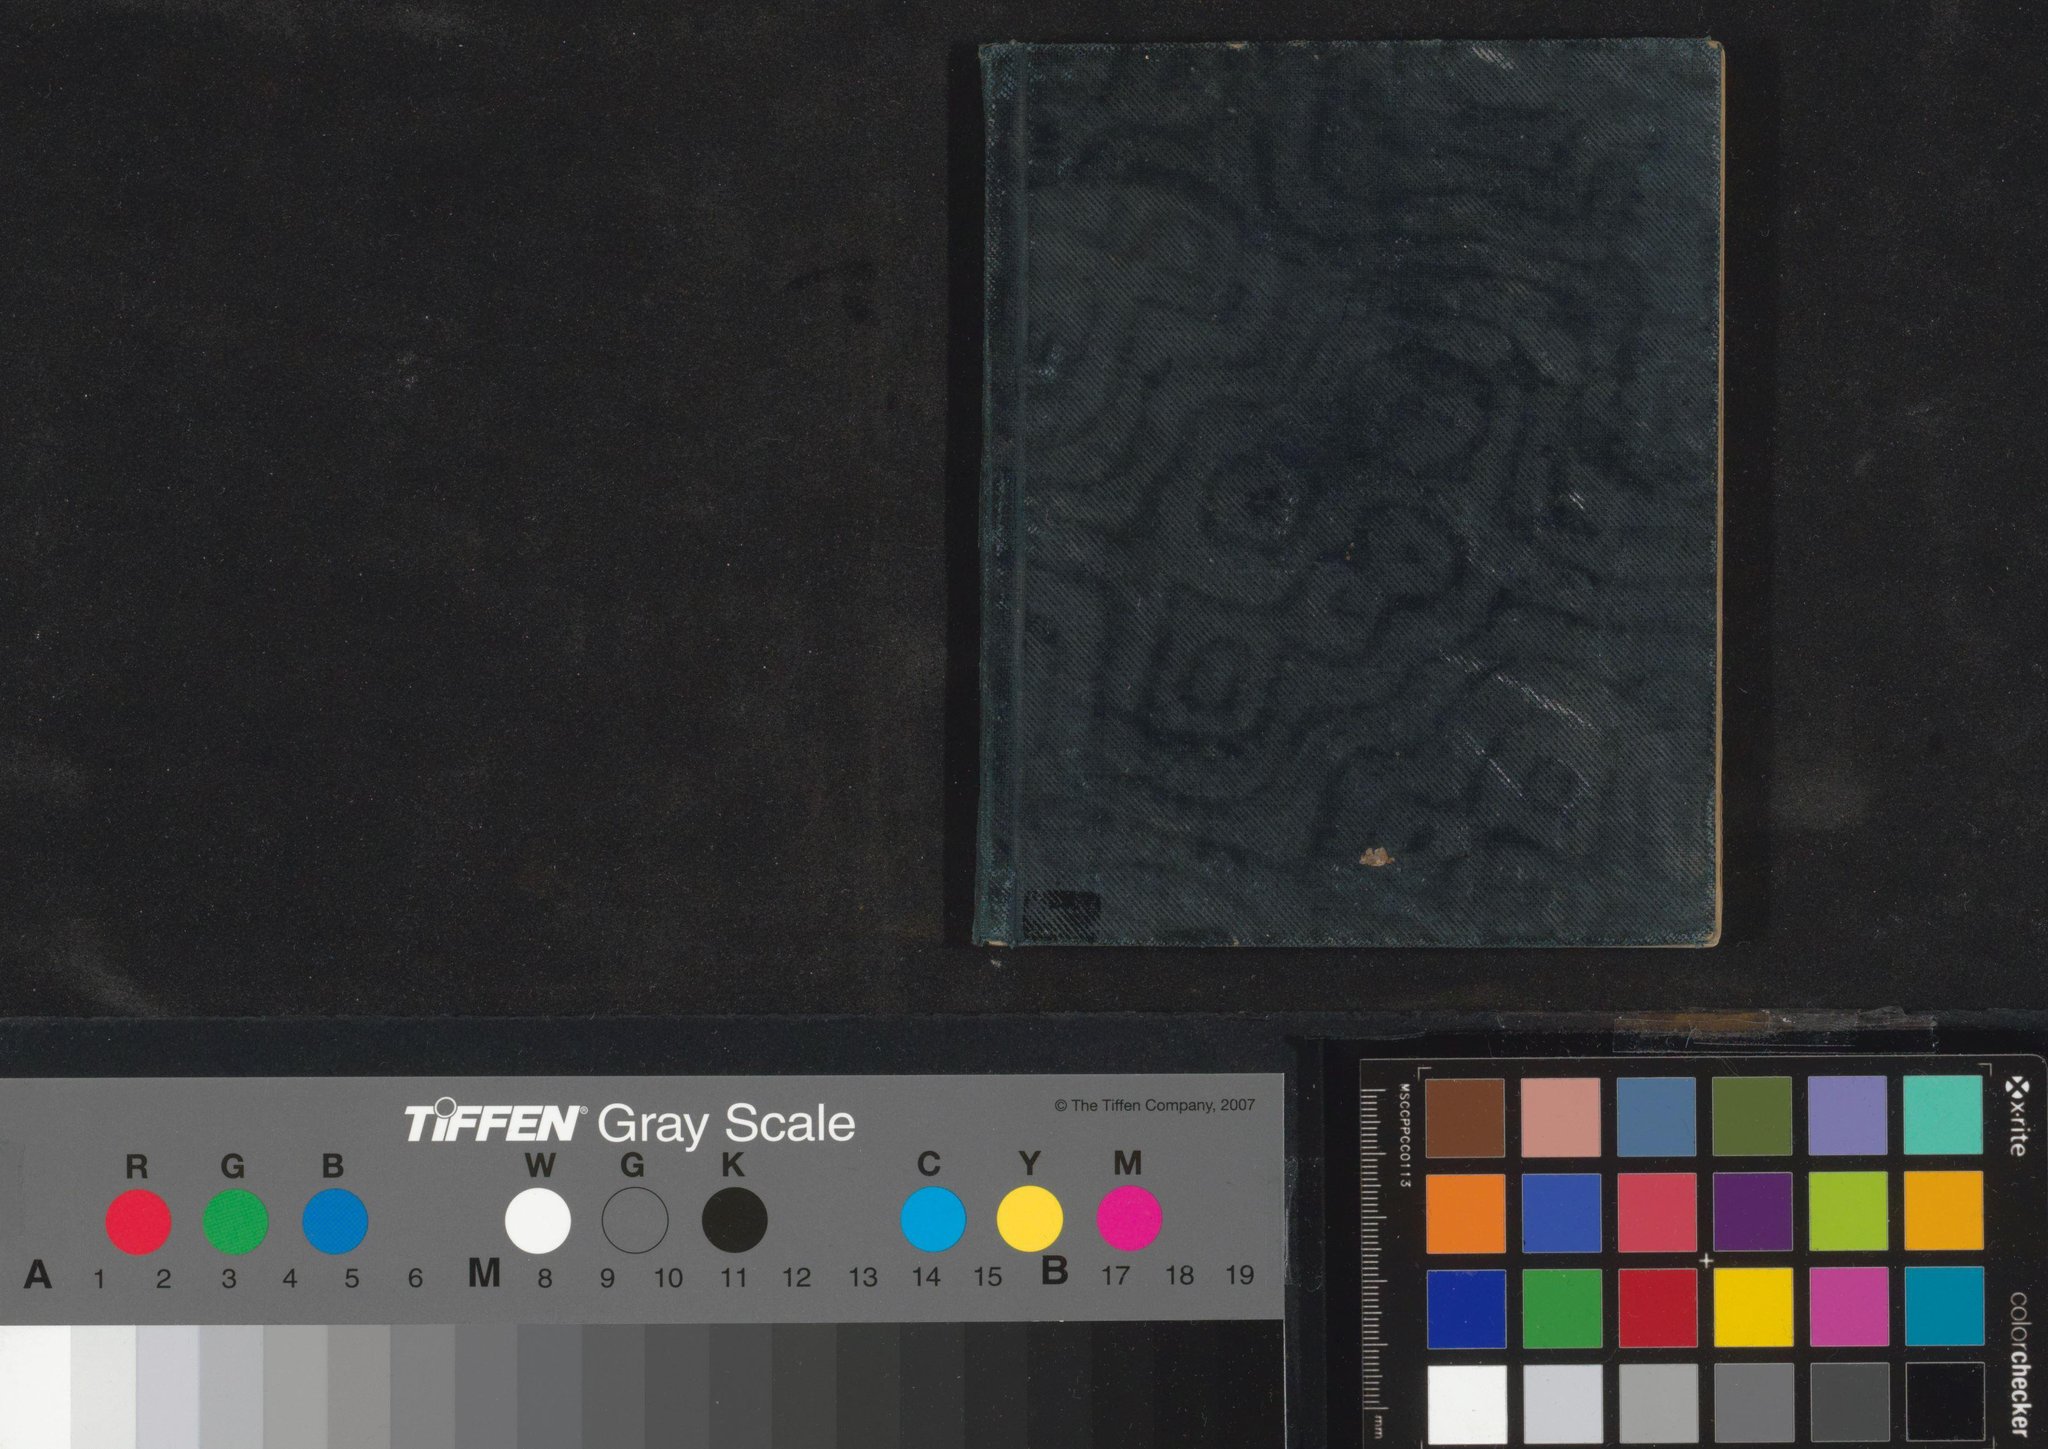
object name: sketchbook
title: Schetsboek met 86 bladen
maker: alfred william rich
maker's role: draughtsman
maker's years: 1856-1921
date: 1892-1893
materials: cardboard, linen, paper, pencil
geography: dover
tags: prospect of village, silhouette of village, windmill in landscape, folk costume, regional costume, antwerp, amsterdam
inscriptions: collector's mark: Lugt 2228a, factory mark: ‘Manufactured by/ PERCY YOUNG,/ 187, Gower St., W.C.’, signature: ‘Alfred Rich's Sketch book/ of Holland visit.’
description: Schetsboek bestaande uit 86 bladen met schetsen gemaakt tijdens een reis naar Nederland beginnend in Calais, via Antwerpen naar Noord-Holland en eindigend in Dover. Voornamelijk figuren in Noord-Hollandse klederdracht, landschappen en stadsgezichten te Zaandam, Volendam, Monnickendam, Amsterdam en Marken.